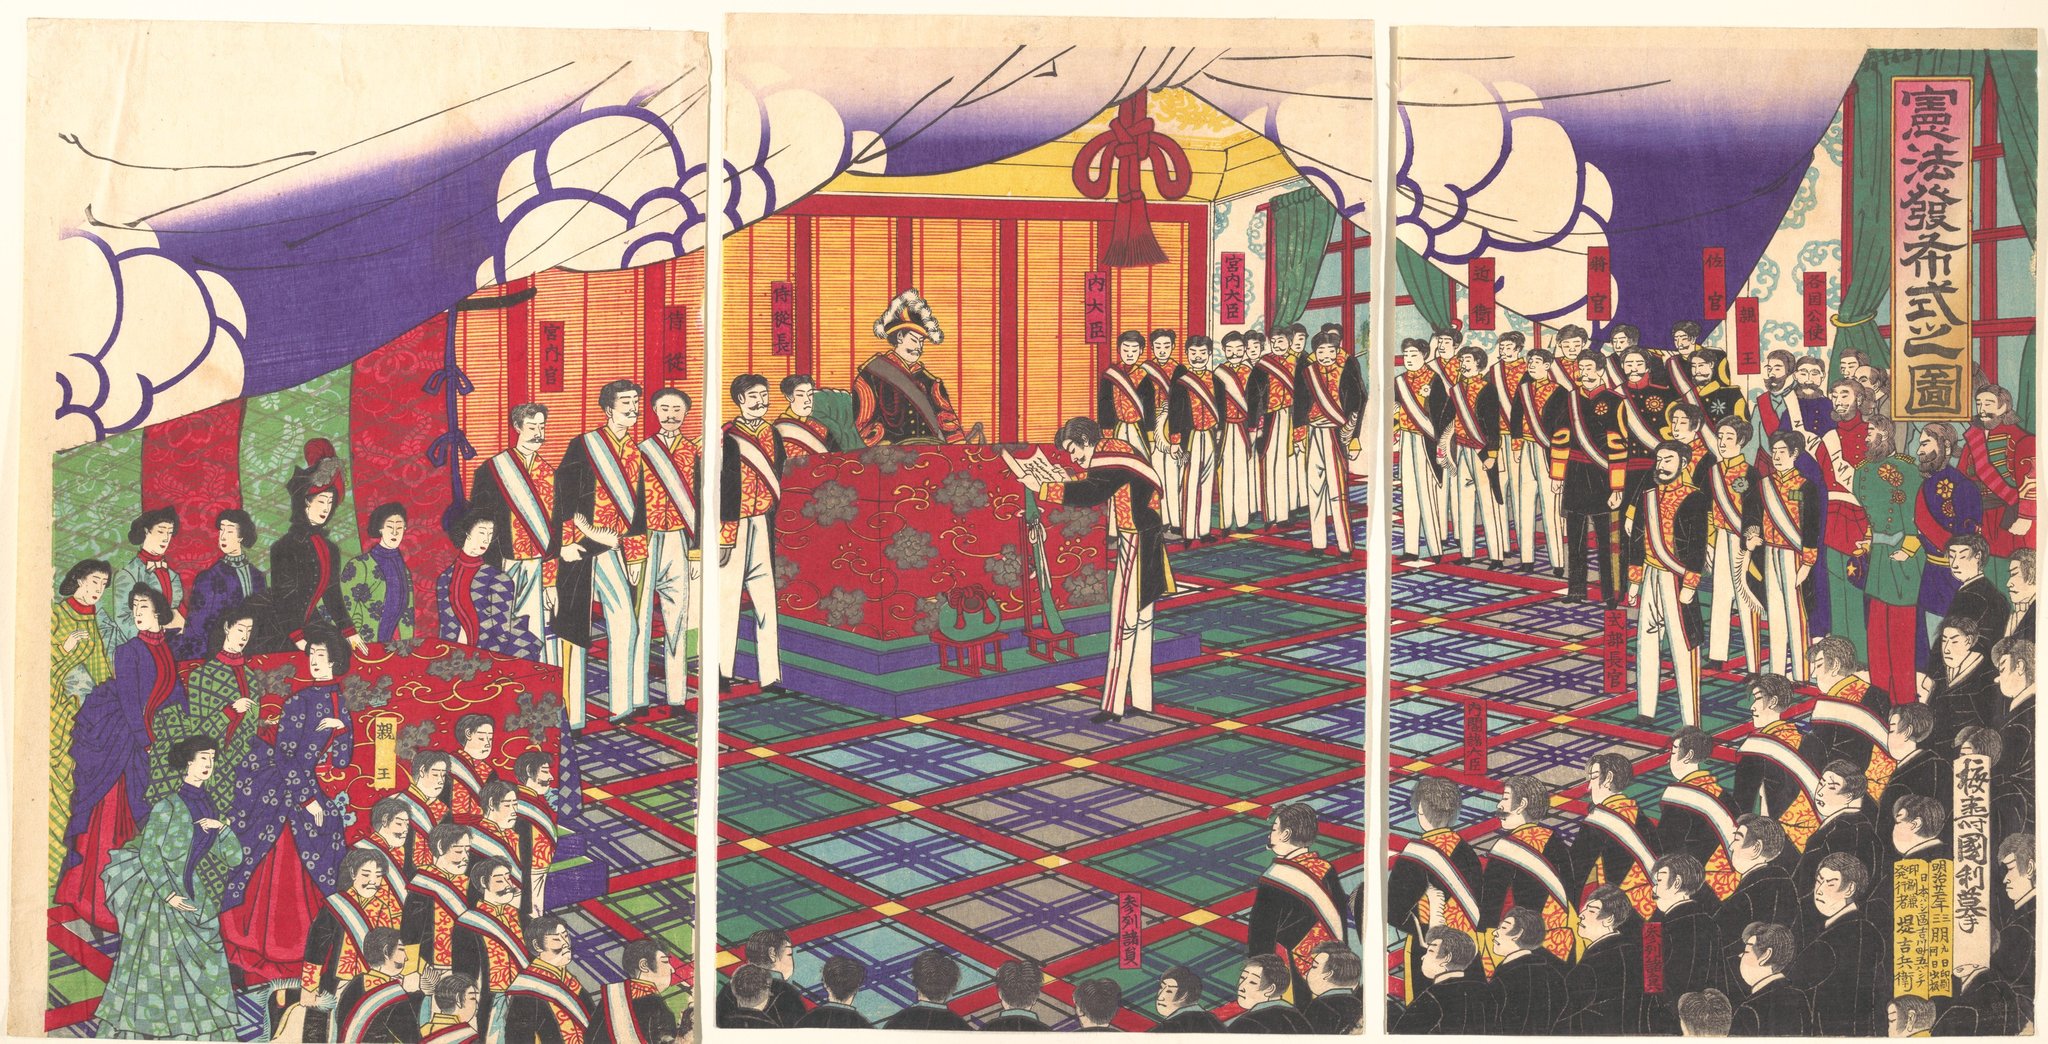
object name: print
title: View of the Issuance of the Constitution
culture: japanese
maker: baiju kunitoshi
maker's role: artist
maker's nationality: japanese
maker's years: 1847-1899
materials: ink, paper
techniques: woodblock print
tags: men,women,ceremony